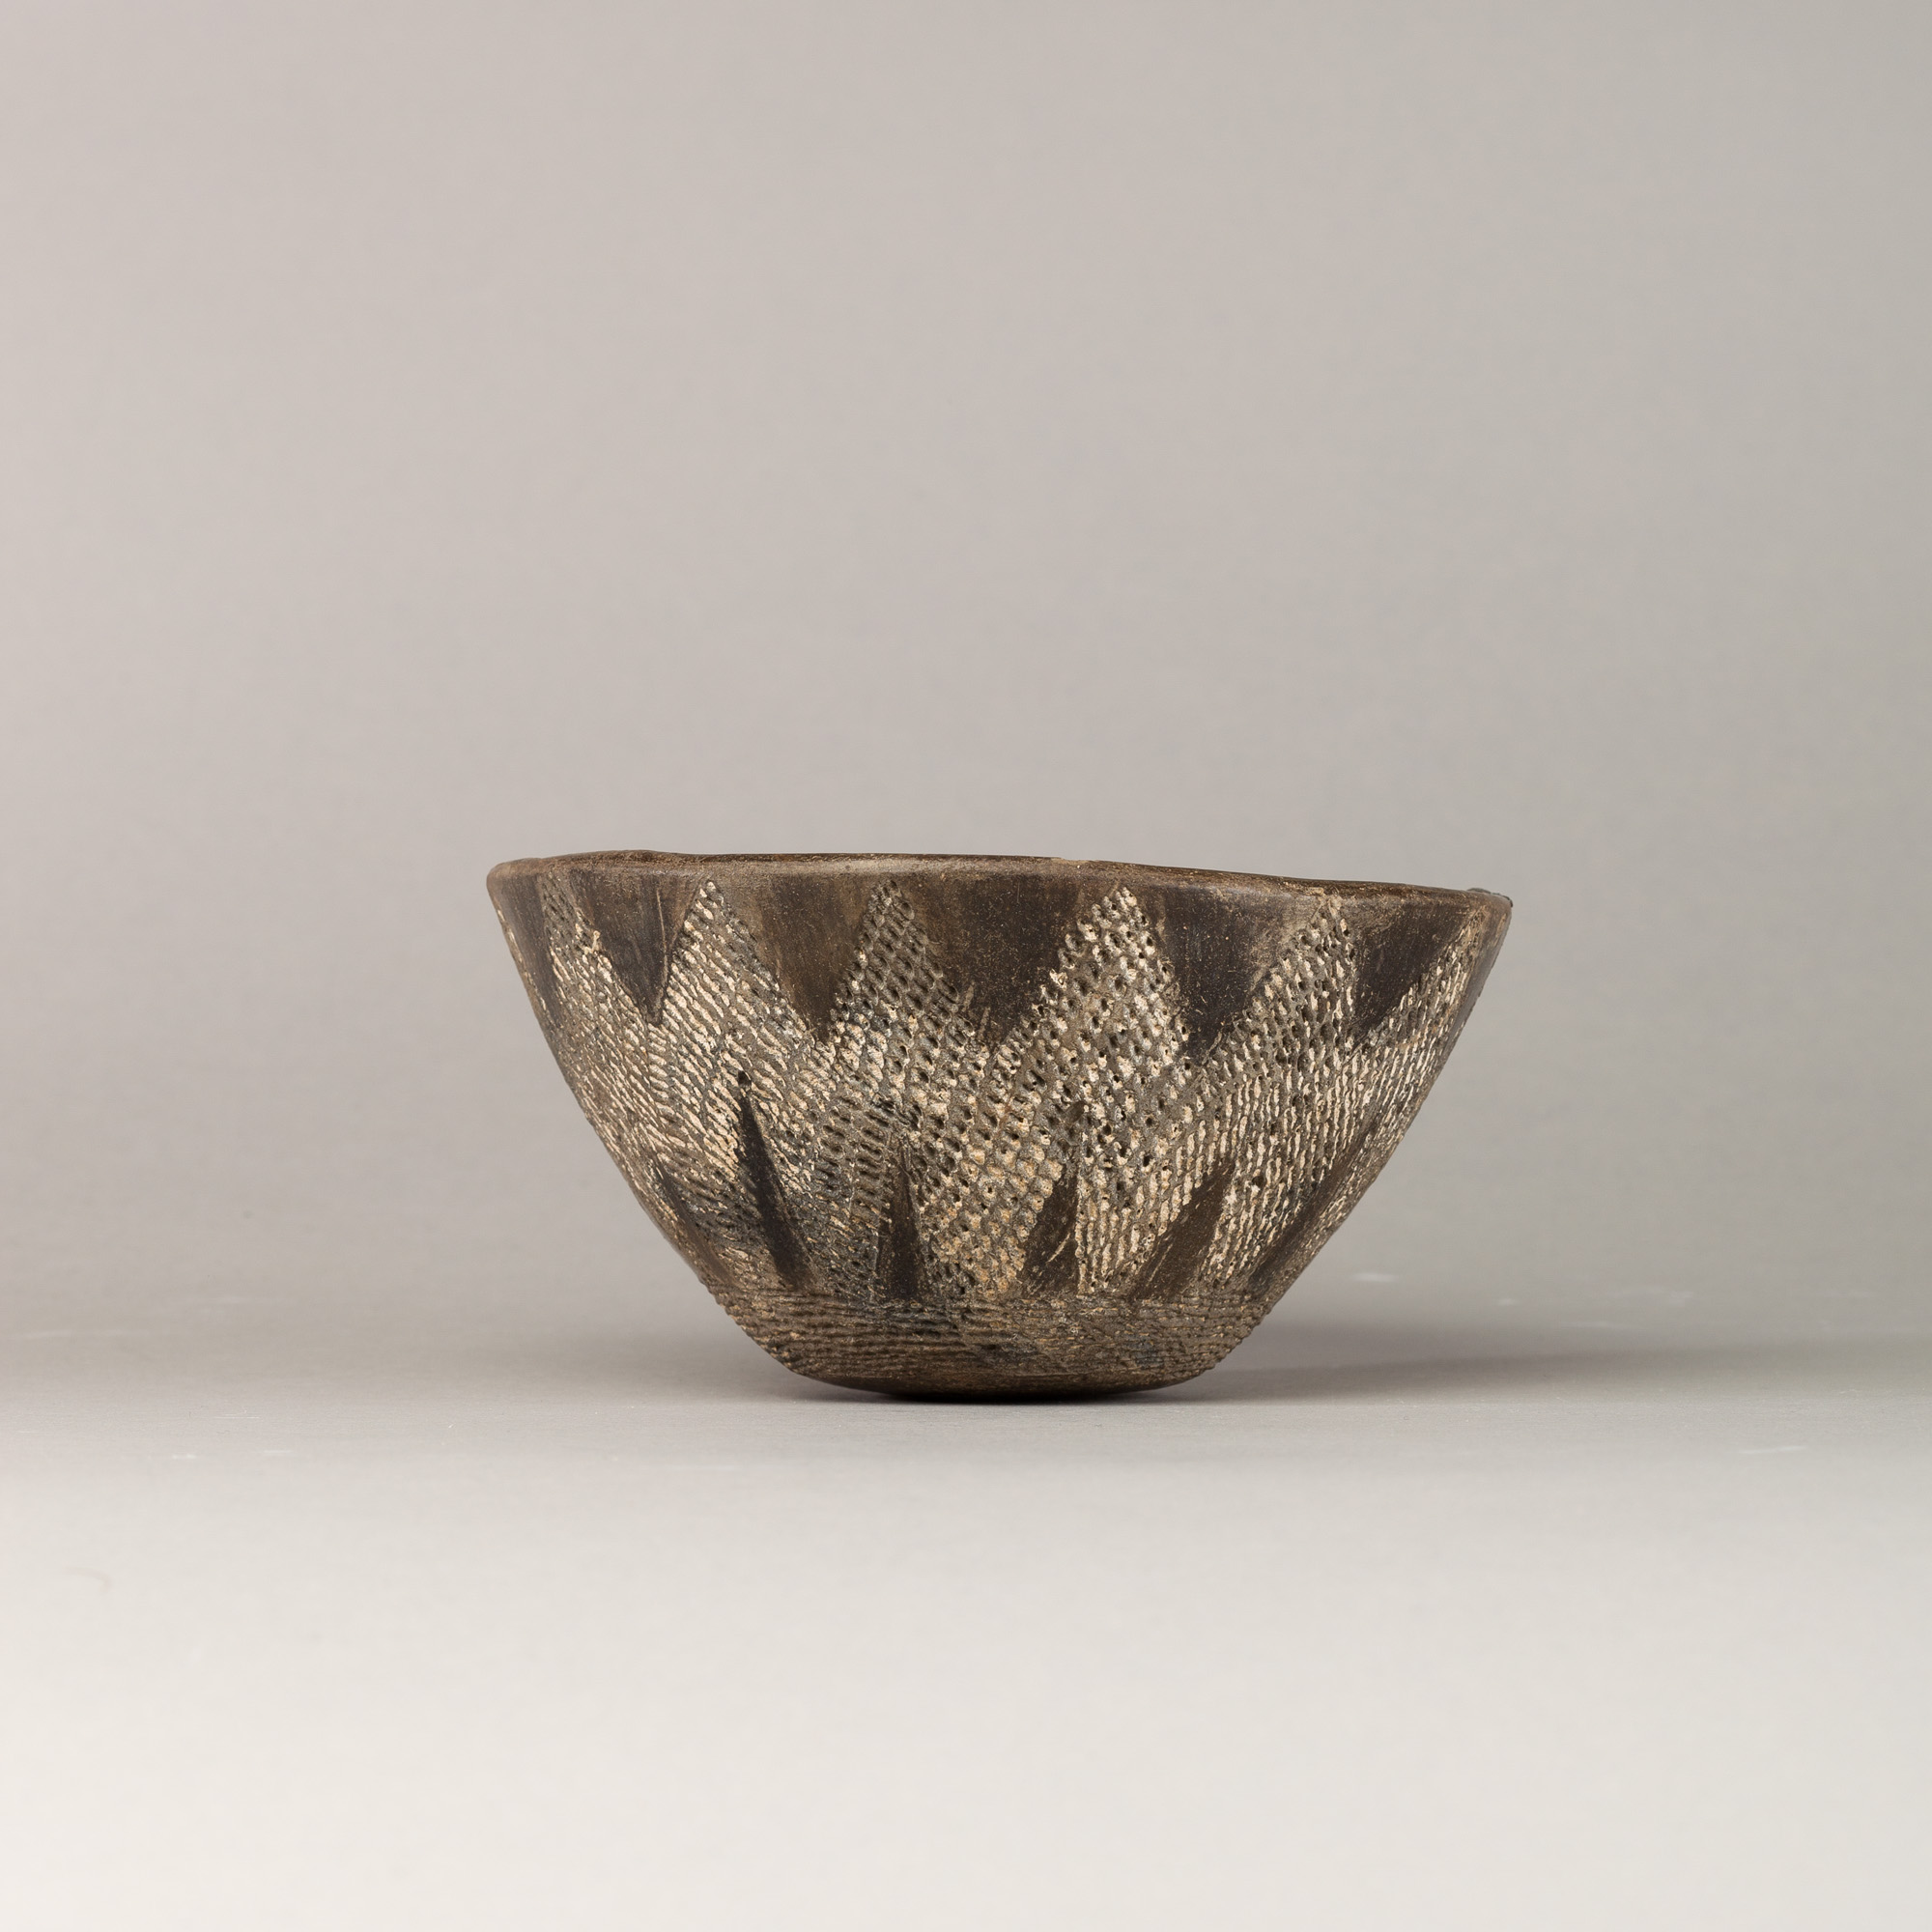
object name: bowl, incised ware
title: Black Incised Ware Bowl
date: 3850-2960 BCE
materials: pottery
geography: egypt